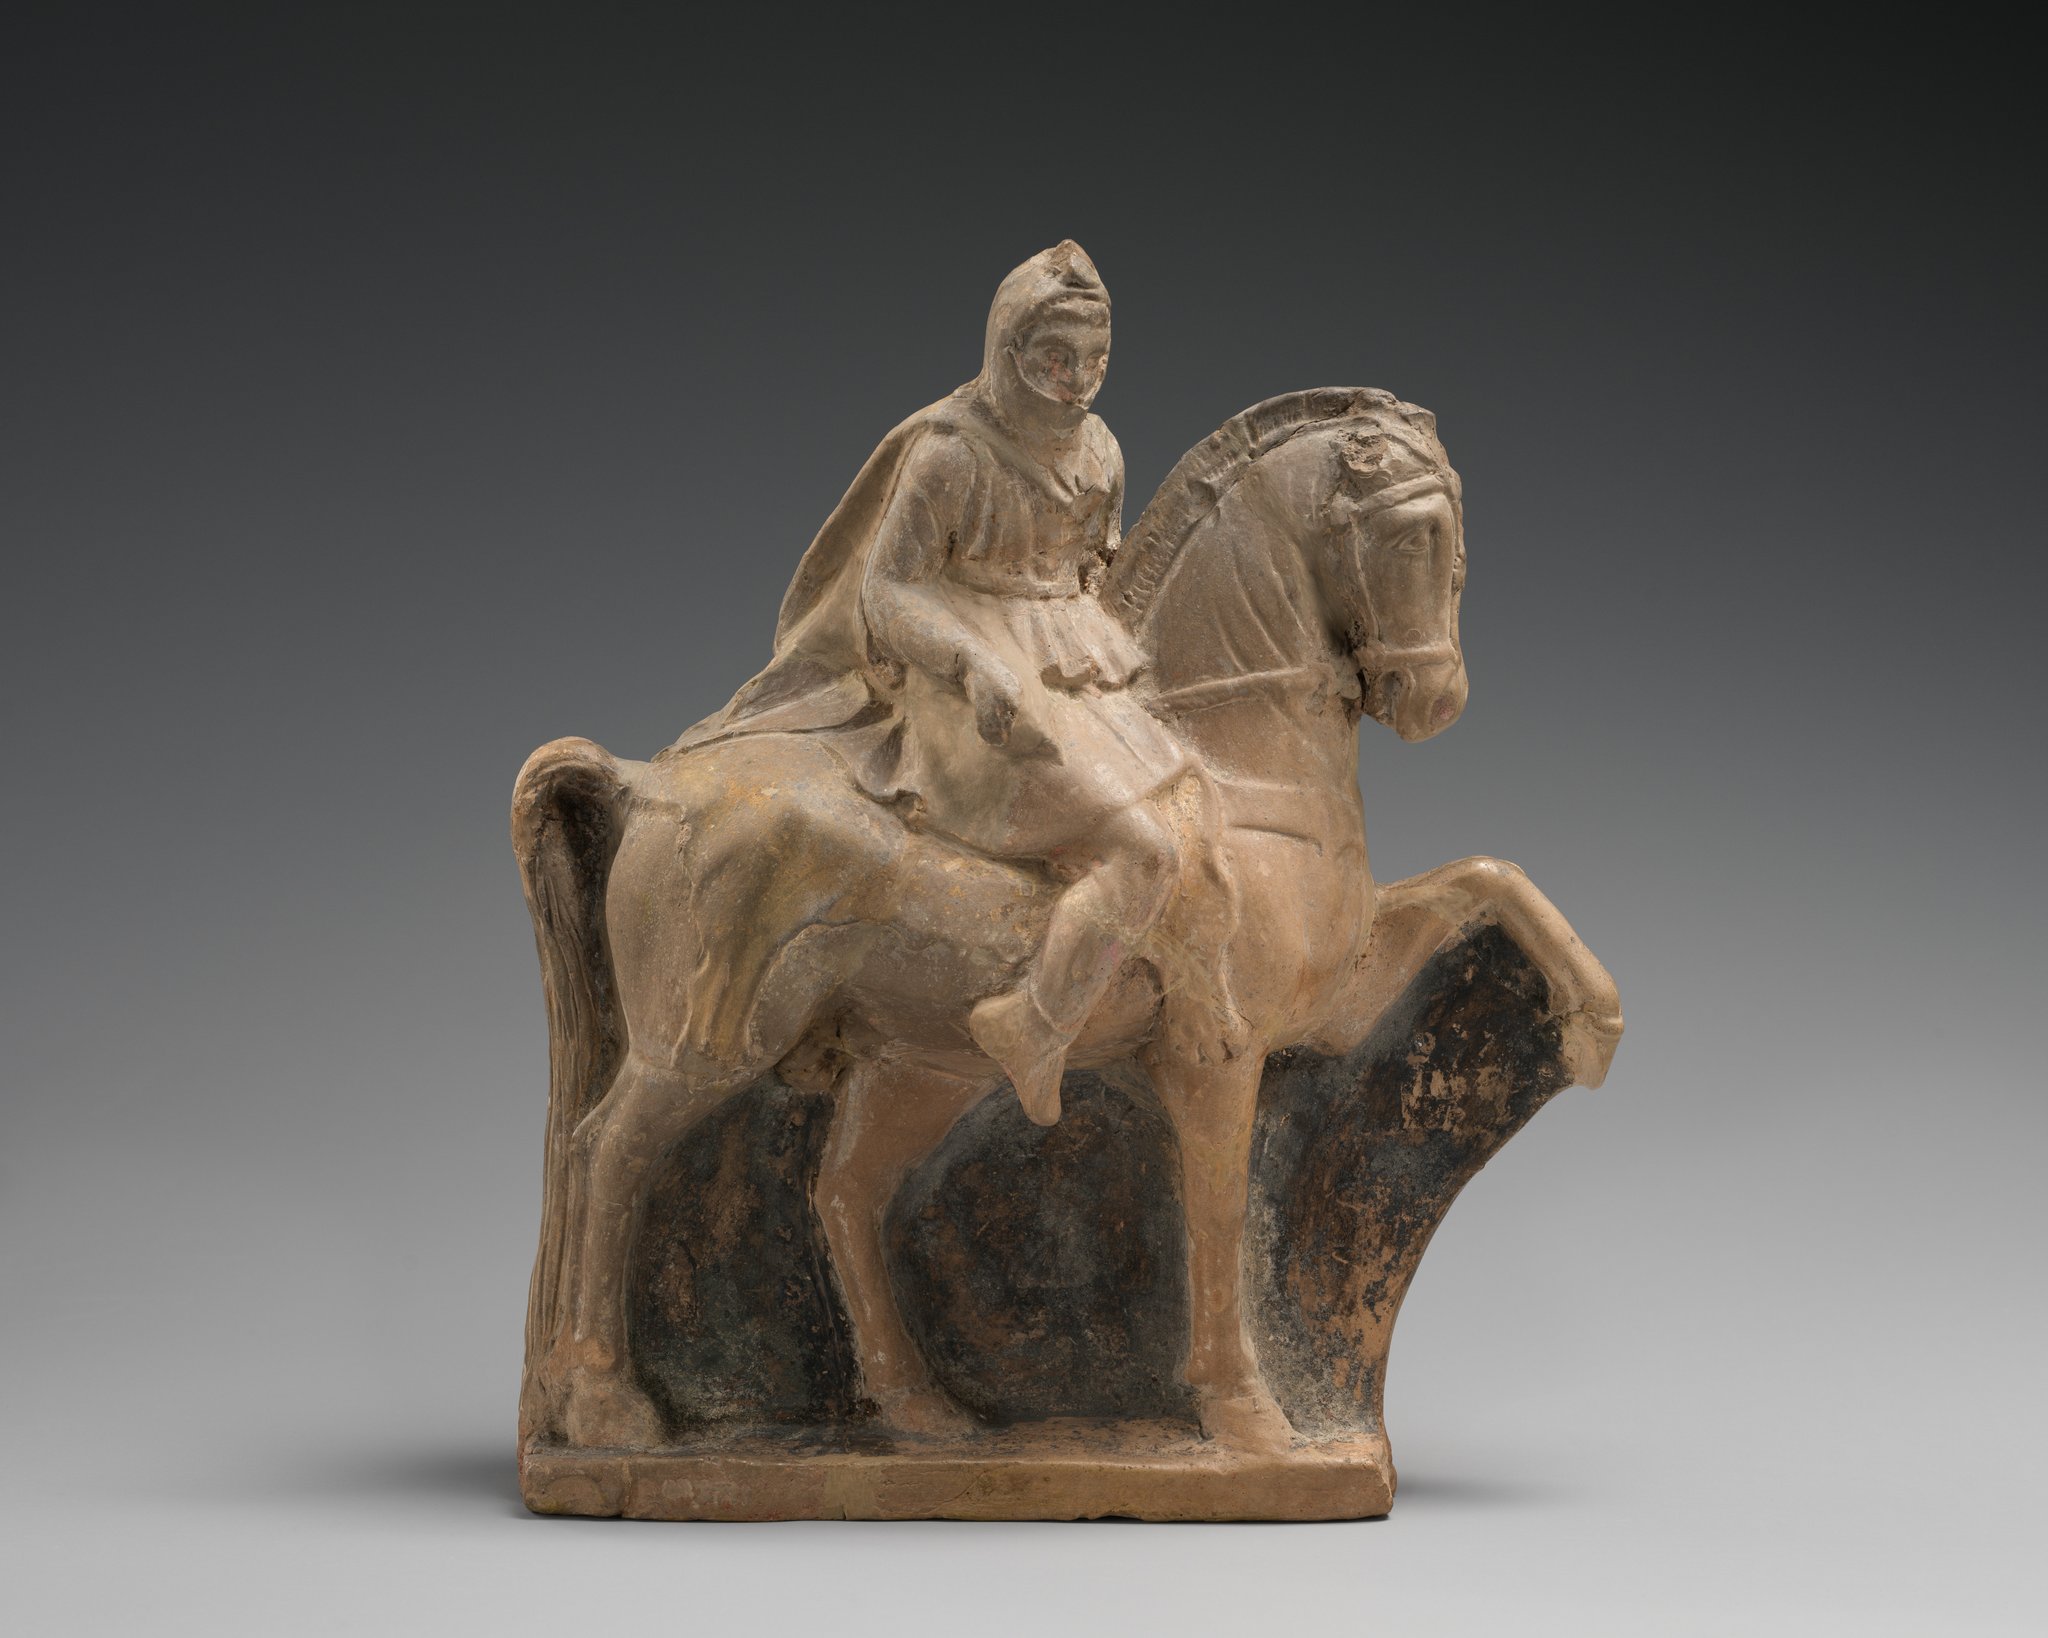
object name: statue of a votary, phrygian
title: Terracotta statuette of a horseman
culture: cypriot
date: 300-201 BCE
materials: terracotta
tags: horses